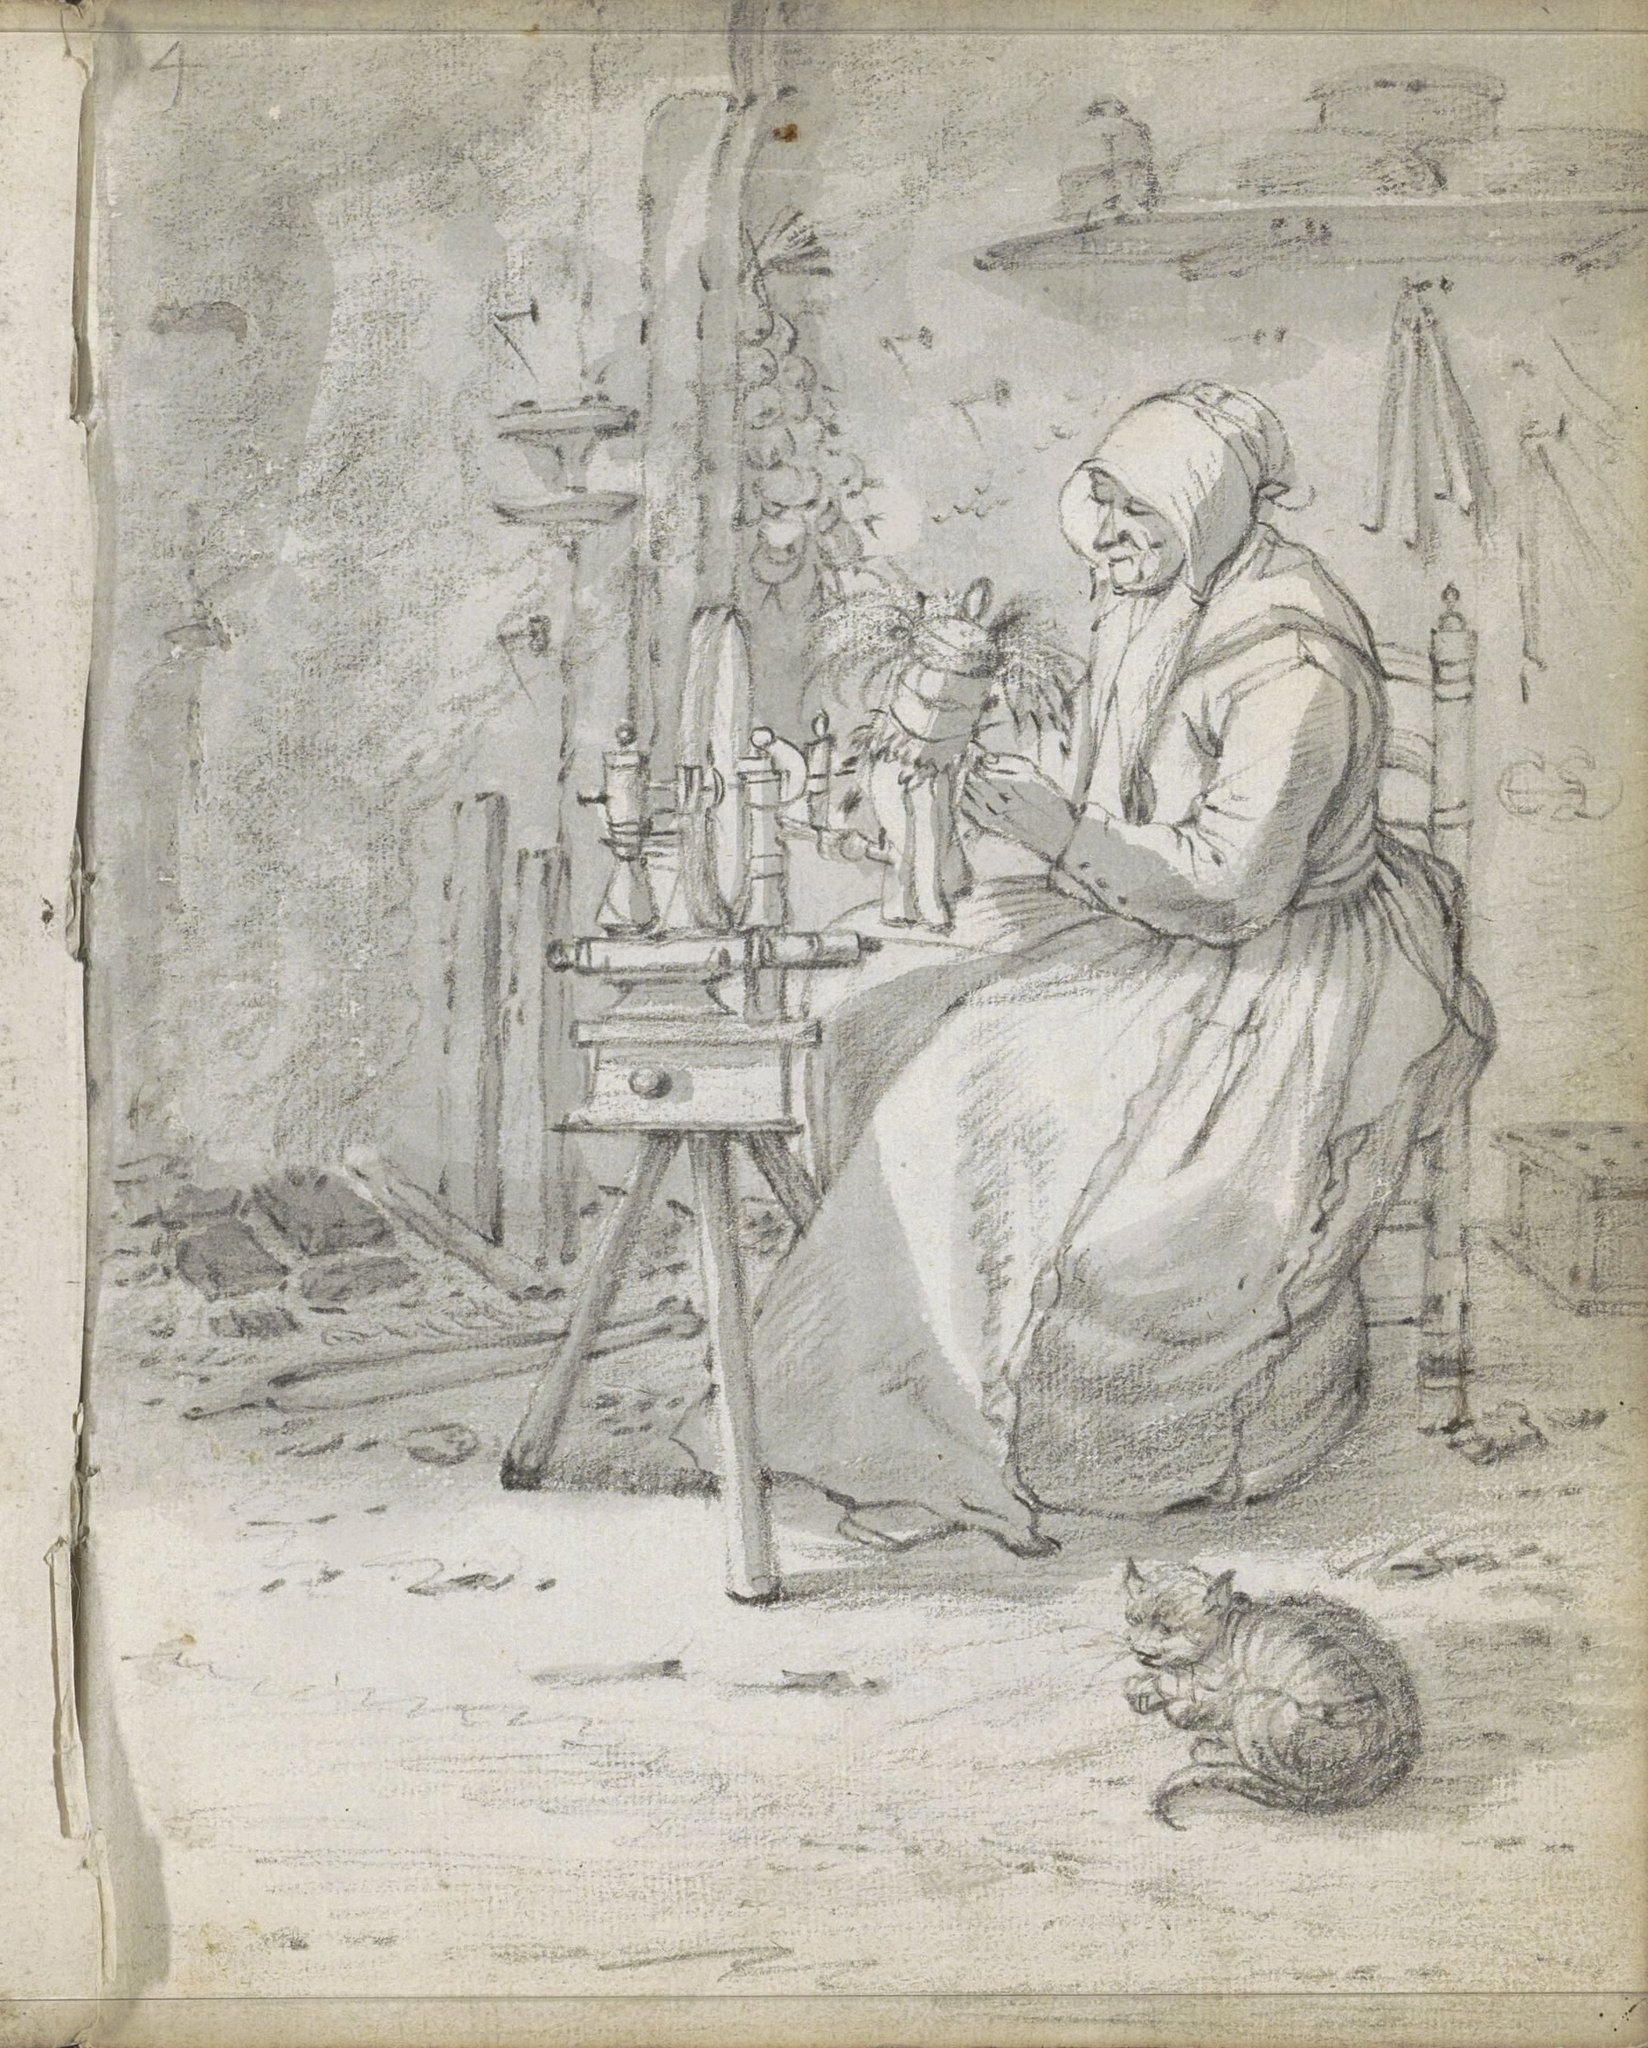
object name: sketchbook leaf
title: Boereninterieur met een vrouw aan een spinnewiel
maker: cornelis saftleven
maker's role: draughtsman, painter, print maker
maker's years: 1607-1681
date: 1666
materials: chalk, ink, paper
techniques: brush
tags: cat, cottage - aa - civic architecture: inside, farmers - aa - female farmer, farmer's wife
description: Blad 4 recto uit een schetsboek met 49 bladen.